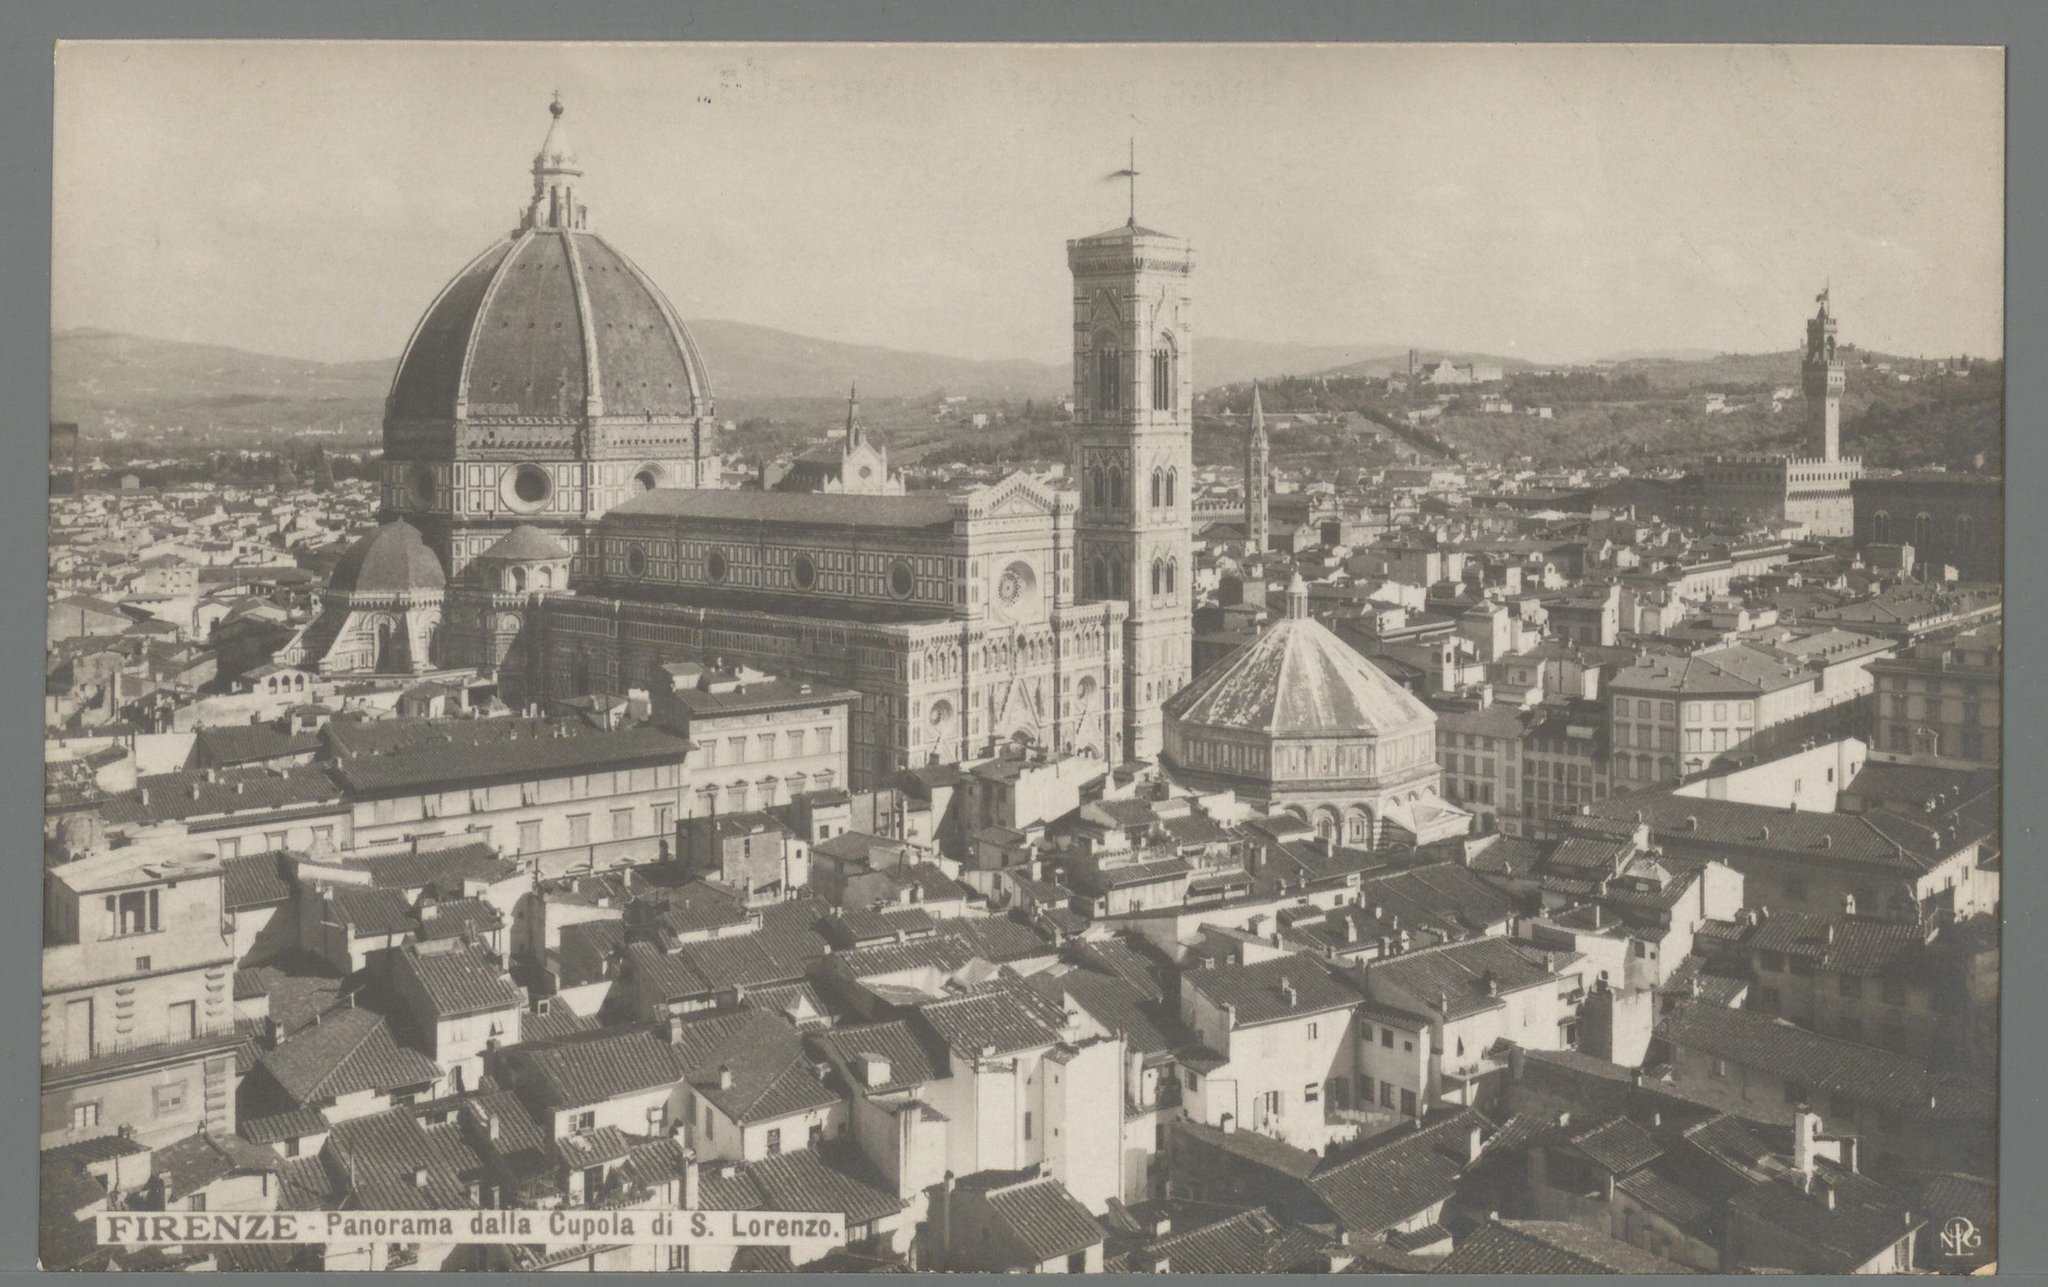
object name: photograph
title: Firenze. Panorama dalla Cupola di S. Lorenzo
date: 1900-1906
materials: paper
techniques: gelatin silver print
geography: milan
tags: river, church (exterior)